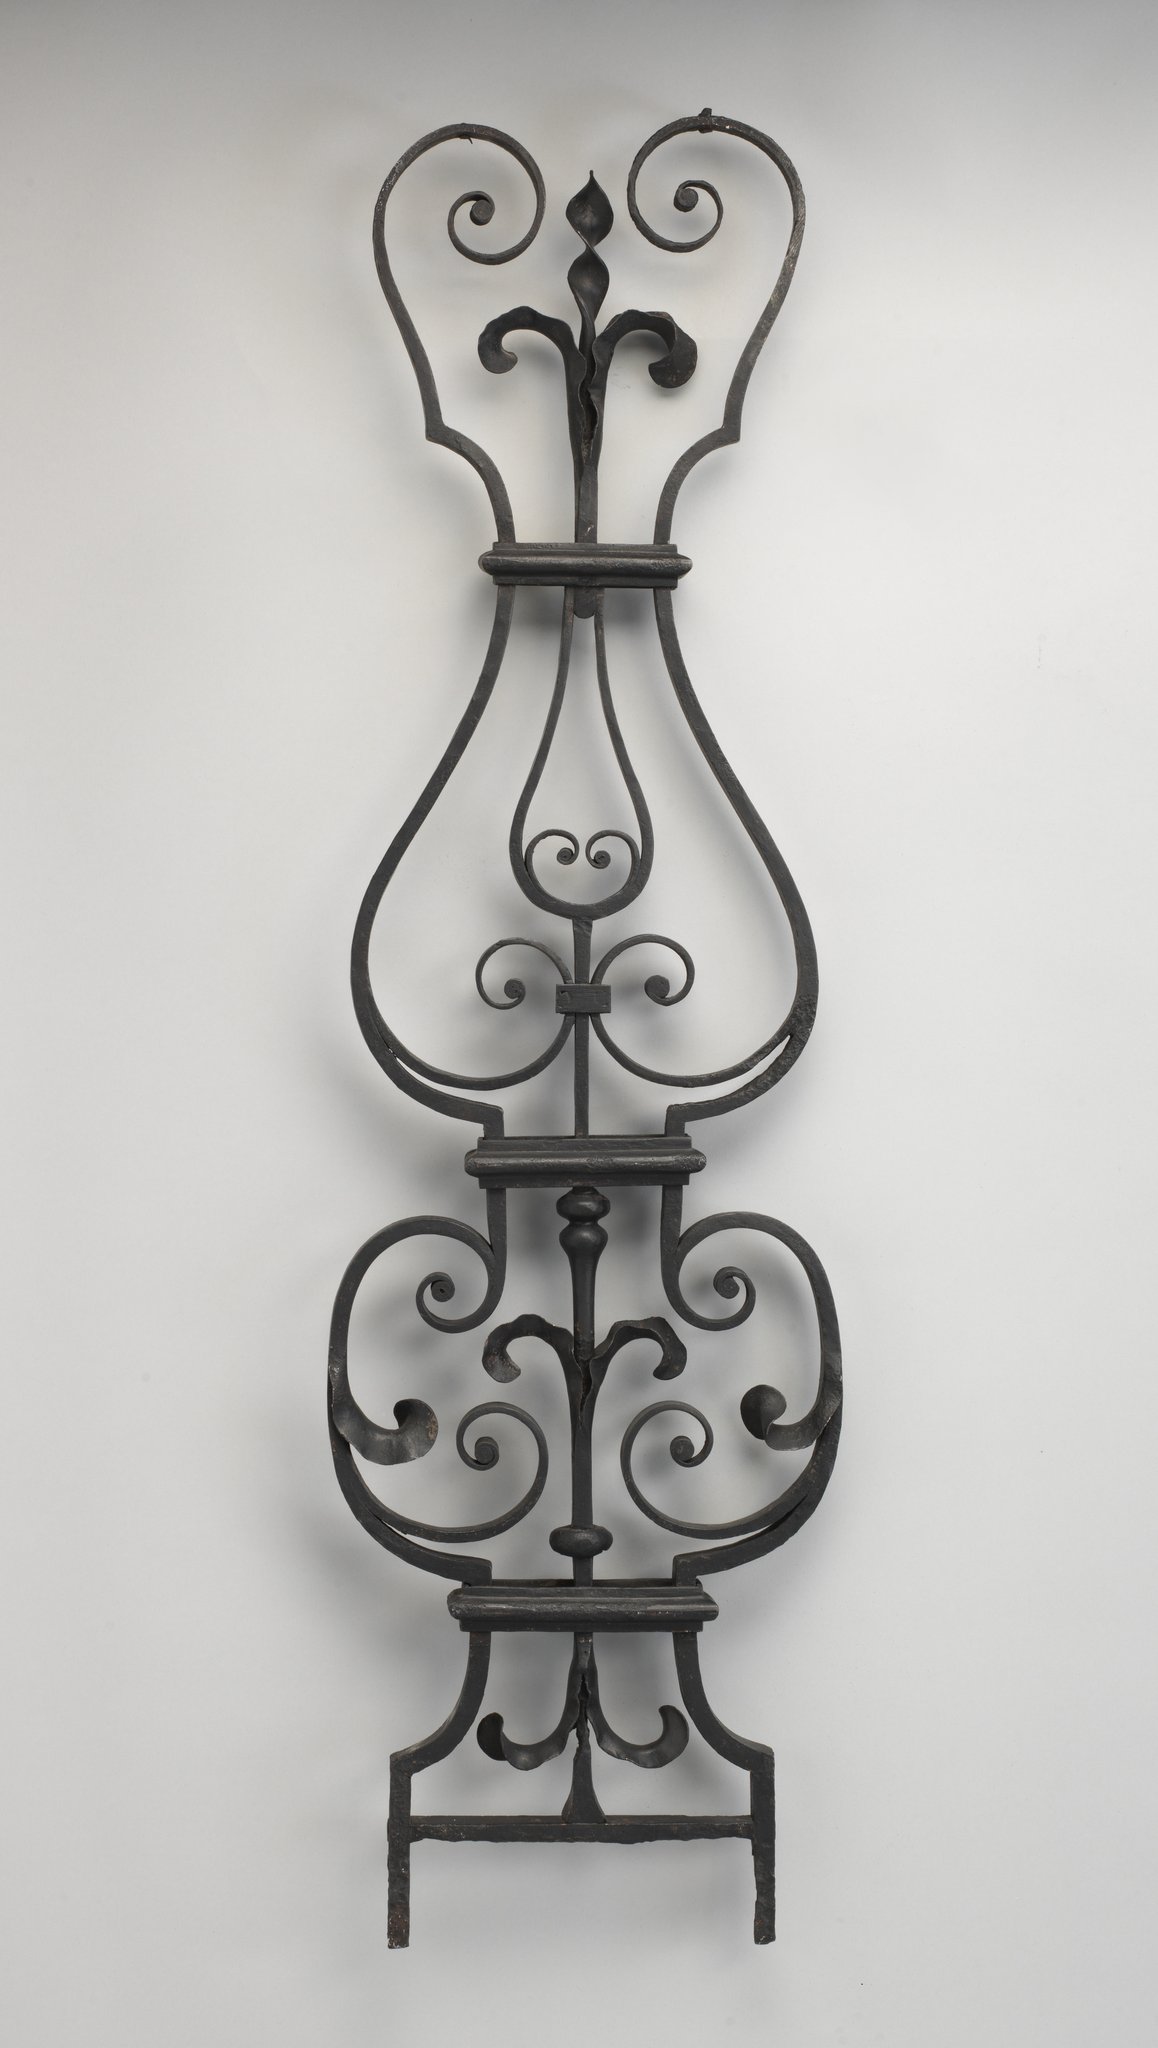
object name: baluster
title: Iron baluster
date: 1730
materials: iron